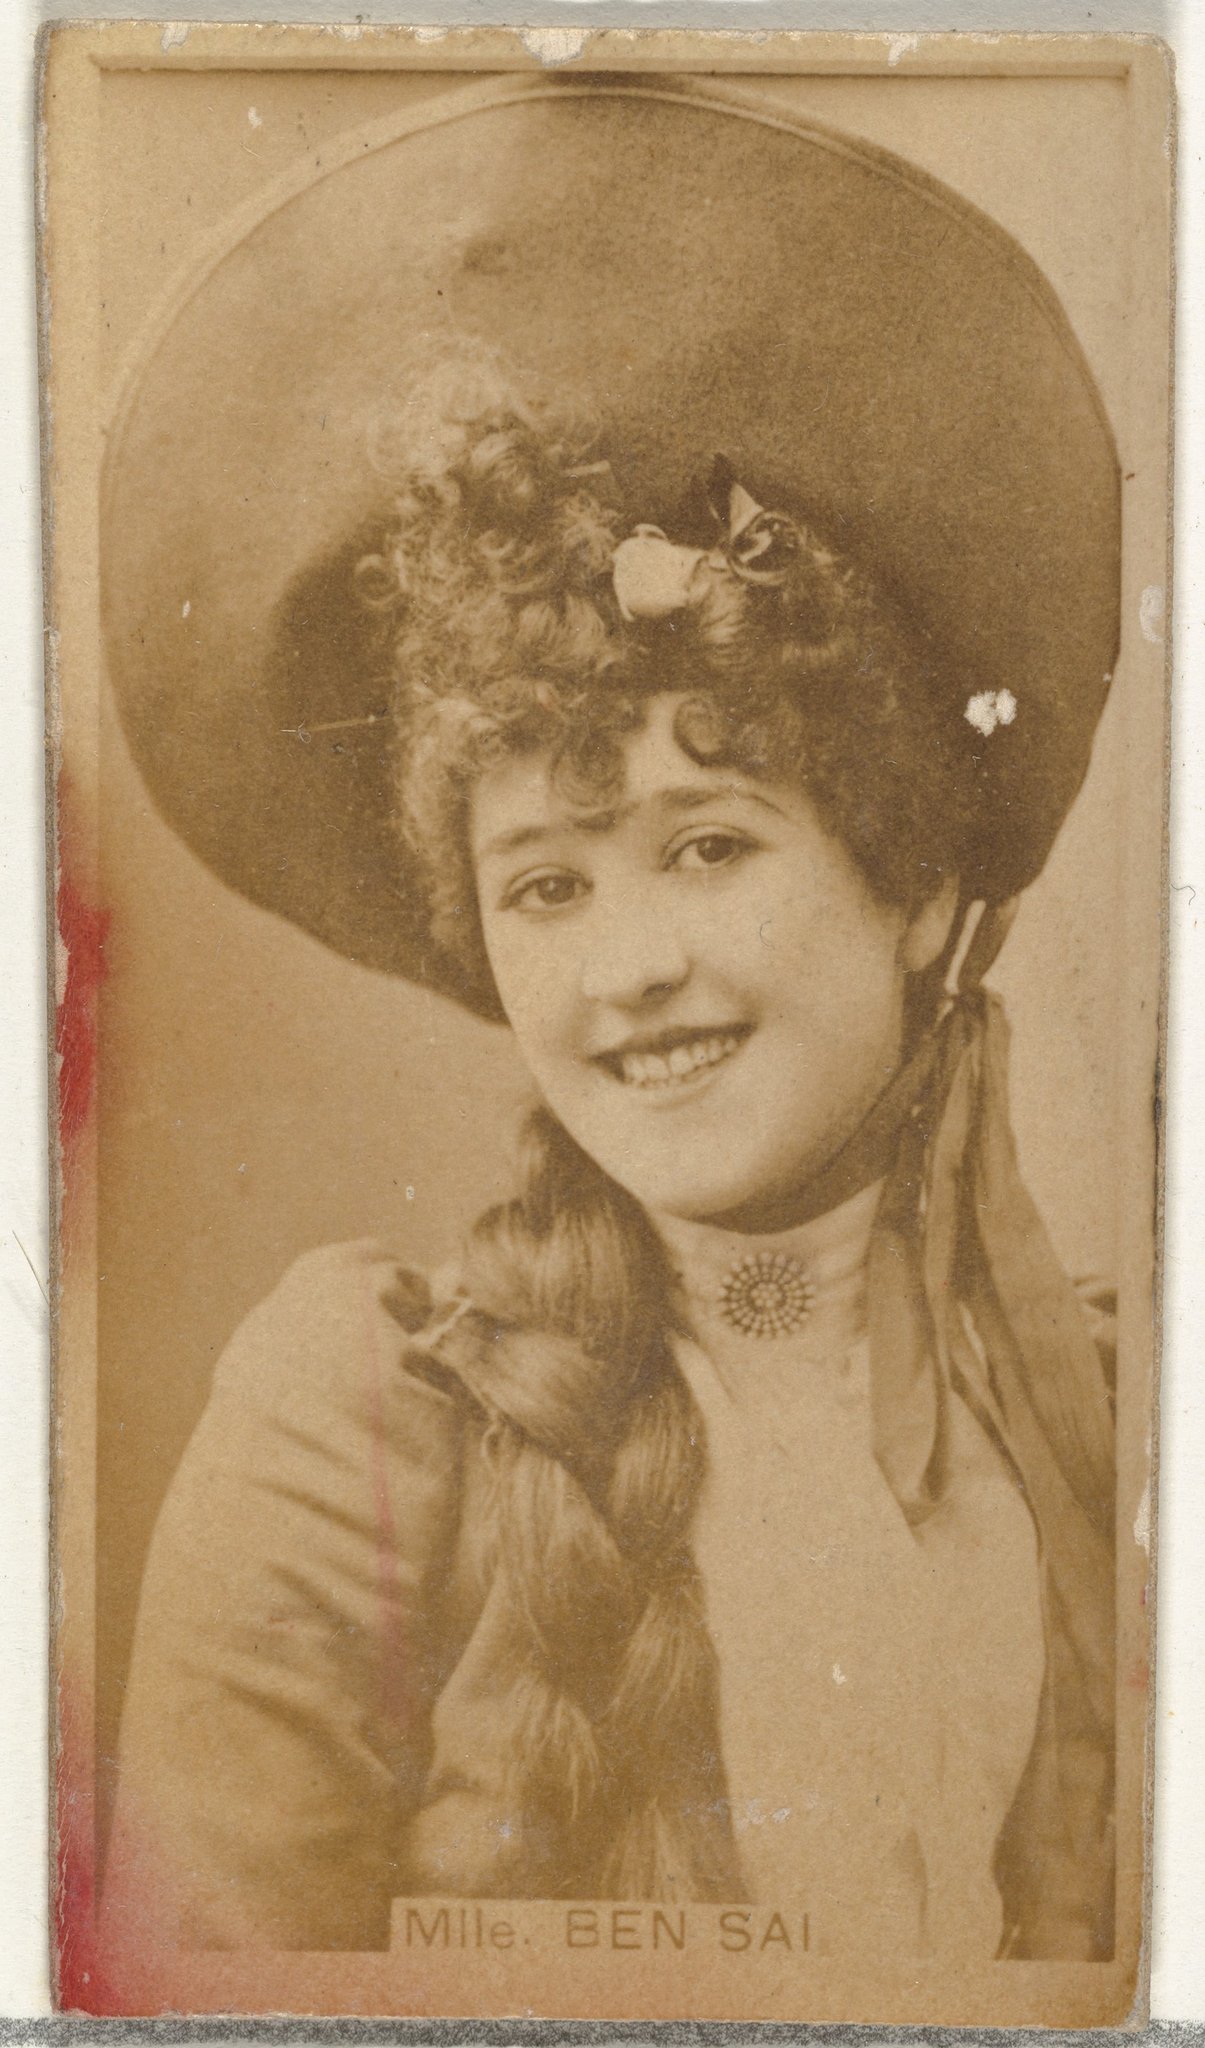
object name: photograph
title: Mlle. Ben Sai, from the Actors and Actresses series (N145-8) issued by Duke Sons & Co. to promote Duke Cigarettes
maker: w. duke, sons & co.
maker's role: publisher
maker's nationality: american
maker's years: 1870-1920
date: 1891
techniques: albumen silver print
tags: portraits,women,actresses